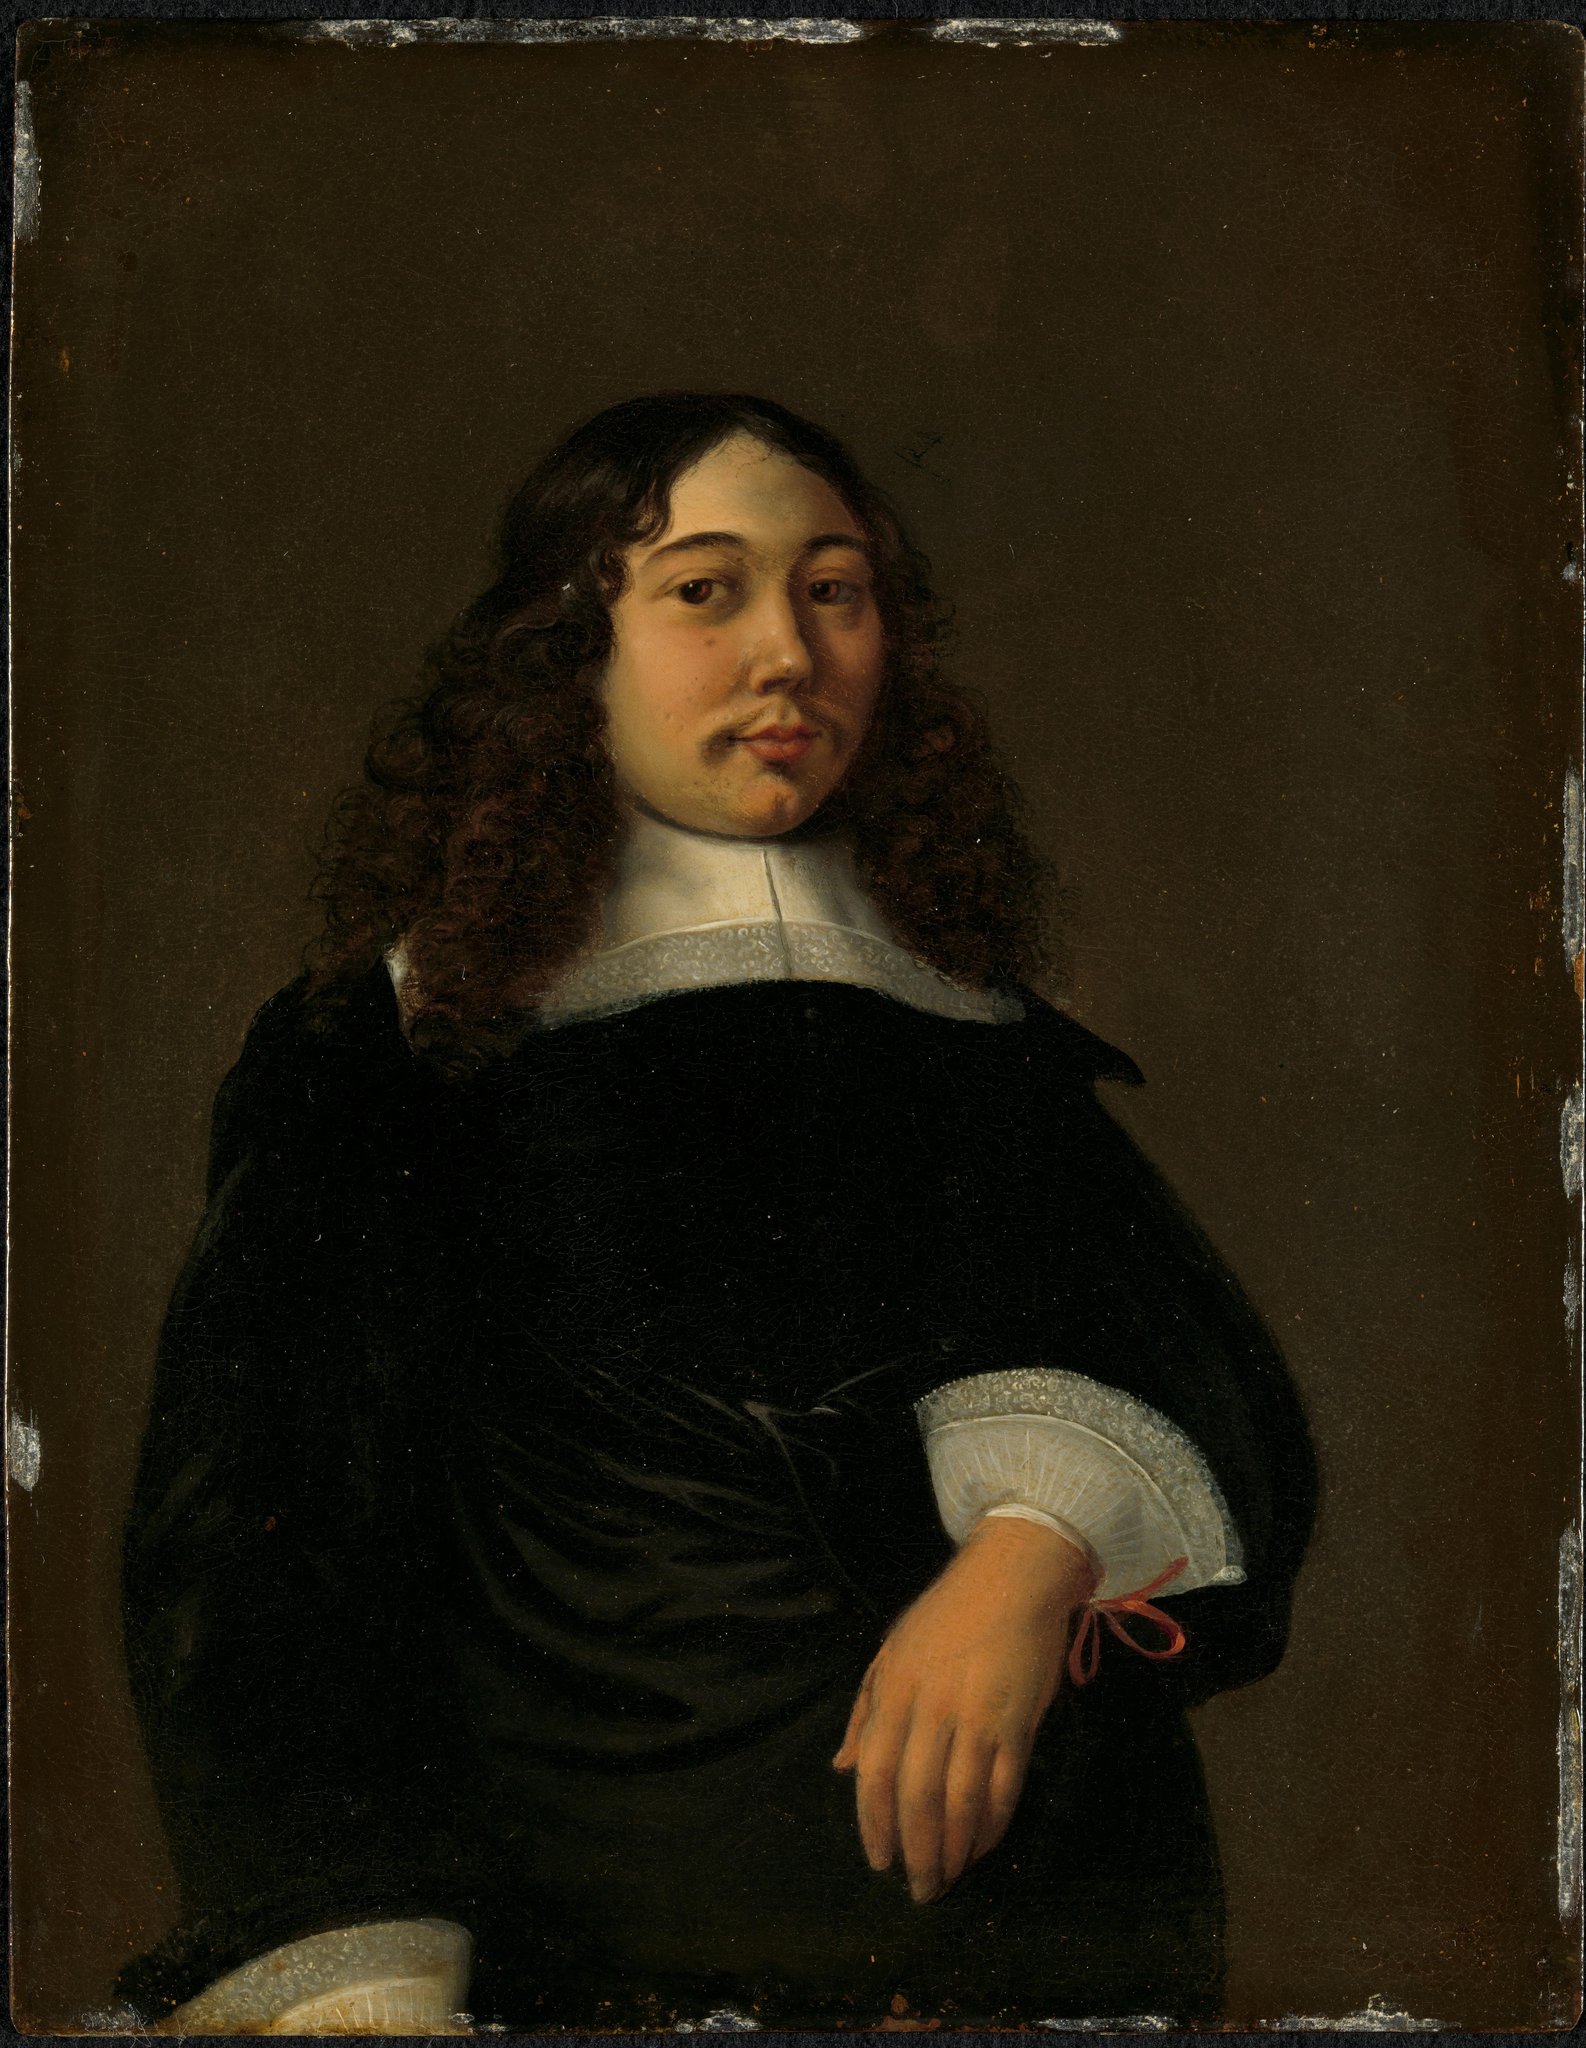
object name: painting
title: Wijnand Wijnands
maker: Anonymous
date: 1660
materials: copper, oil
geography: netherlands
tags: historical persons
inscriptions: inscription: ‘Wynand Wynands’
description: Portret van Wijnand Wijnands. Staand, ten halven lijve, naar rechts.